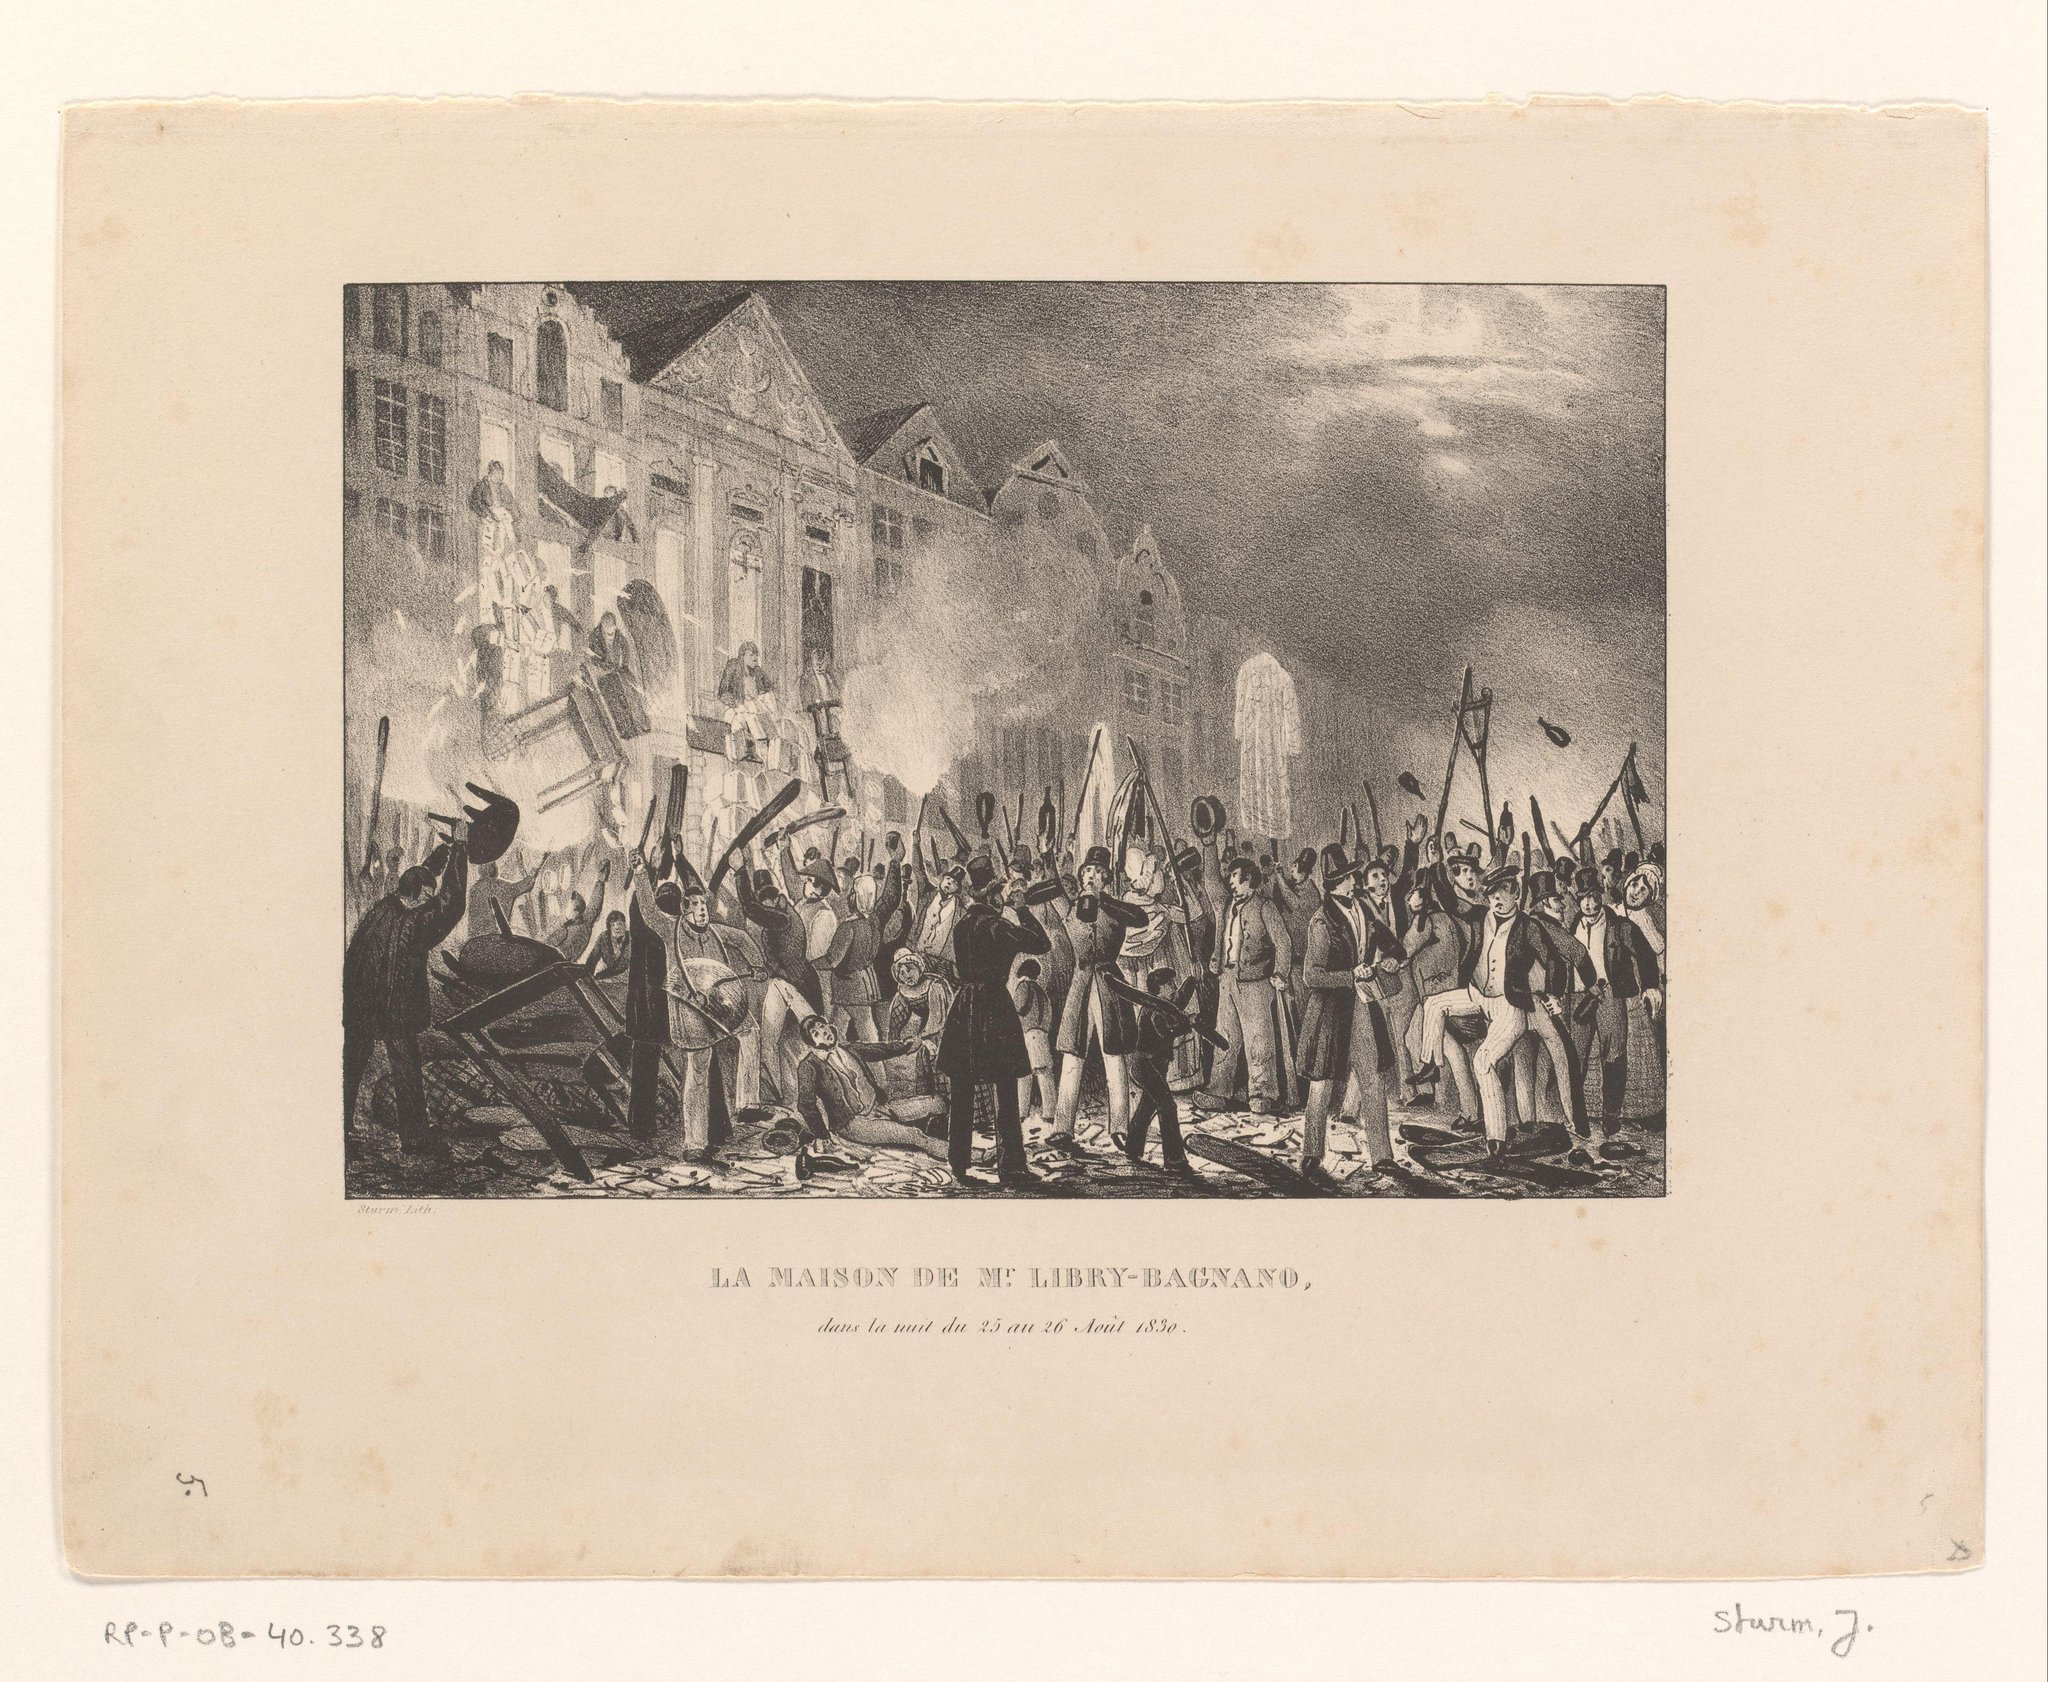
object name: print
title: La maison de mr. Libry-Bagnano, dans la nuit du 25 au 26 Août 1830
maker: jacques sturm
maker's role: print maker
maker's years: 1807-1844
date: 1830-1831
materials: paper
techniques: lithograph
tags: amsterdam, printer, publisher, plundering ~ riot, brussels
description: Onderdeel van een groep prenten uit verschillende andere series verwant aan de platen in het recueil over de gebeurtenissen tijdens de Belgische Revolutie in Brussel, Antwerpen en andere steden in de periode van 25 augustus 1830 tot 27 maart 1831. Uitgegeven in een serie van 23 prenten getiteld: Evénemens de la Belgique Dessinés sur les lieux par des témoins oculaires. Brussel: Jean Baptiste Jobard, [1831].